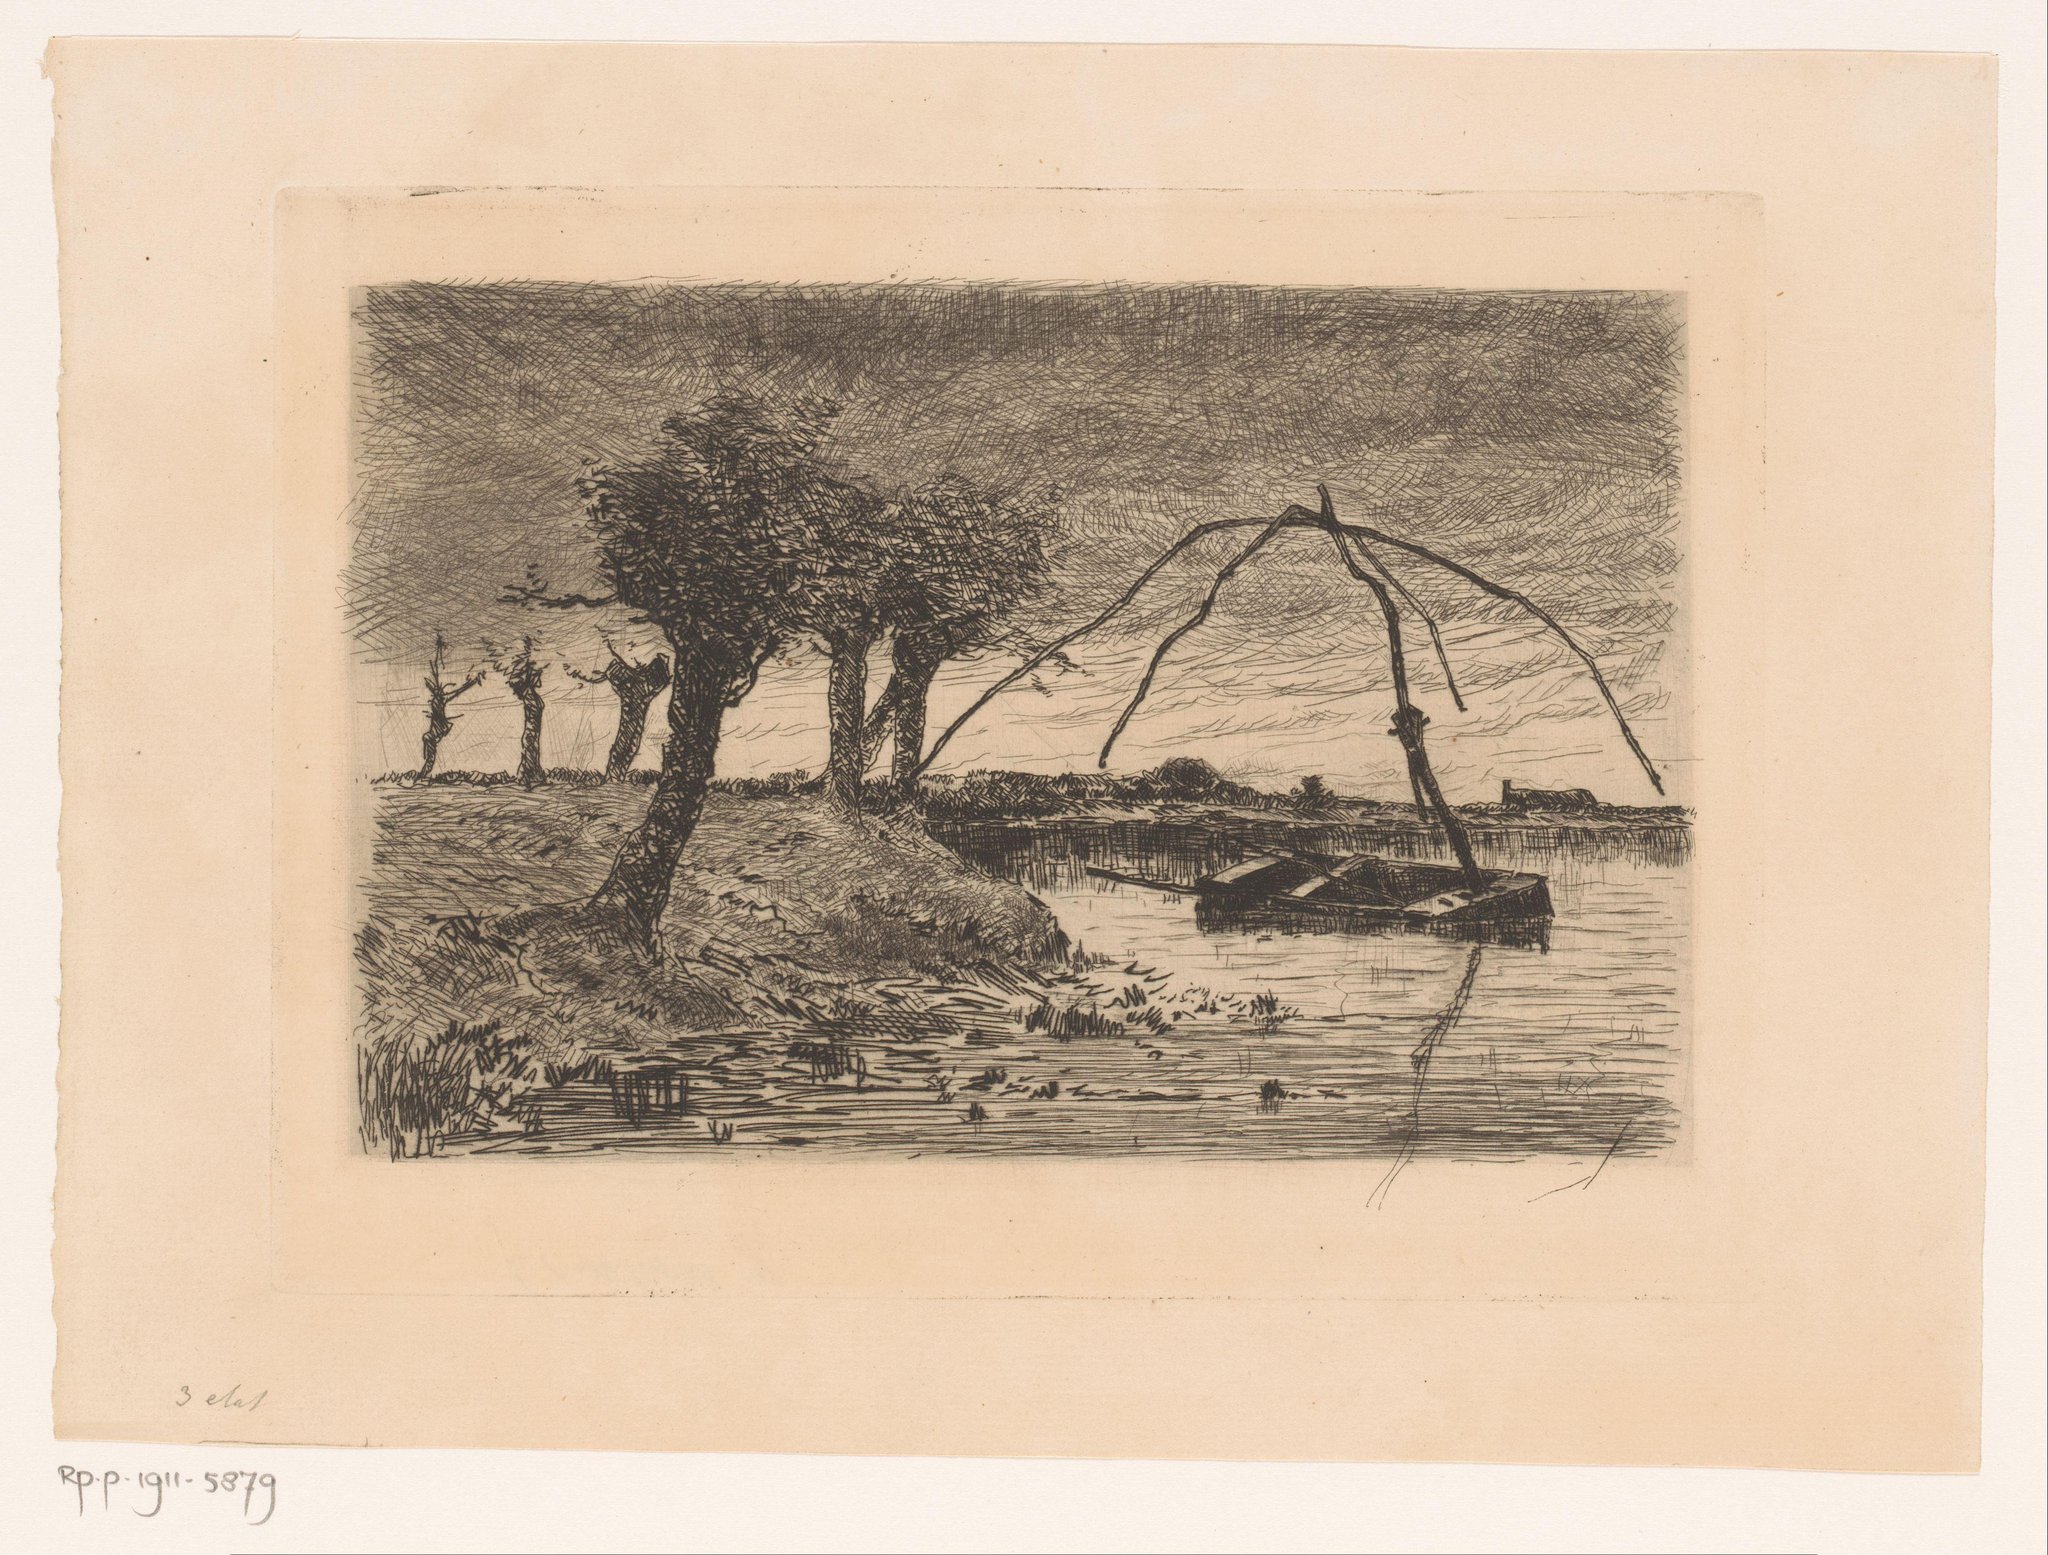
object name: print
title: Landschap met knotwilgen, in het water een roeiboot met een totebel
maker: adrien le mayeur de merprés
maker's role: print maker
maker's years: 1844-1923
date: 1854-1911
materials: paper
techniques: etching, intaglio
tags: fishing net, rowing-boat, canoe, etc., trees: willow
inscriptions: collector's mark: Lugt 2228, annotation: ‘3 etat’